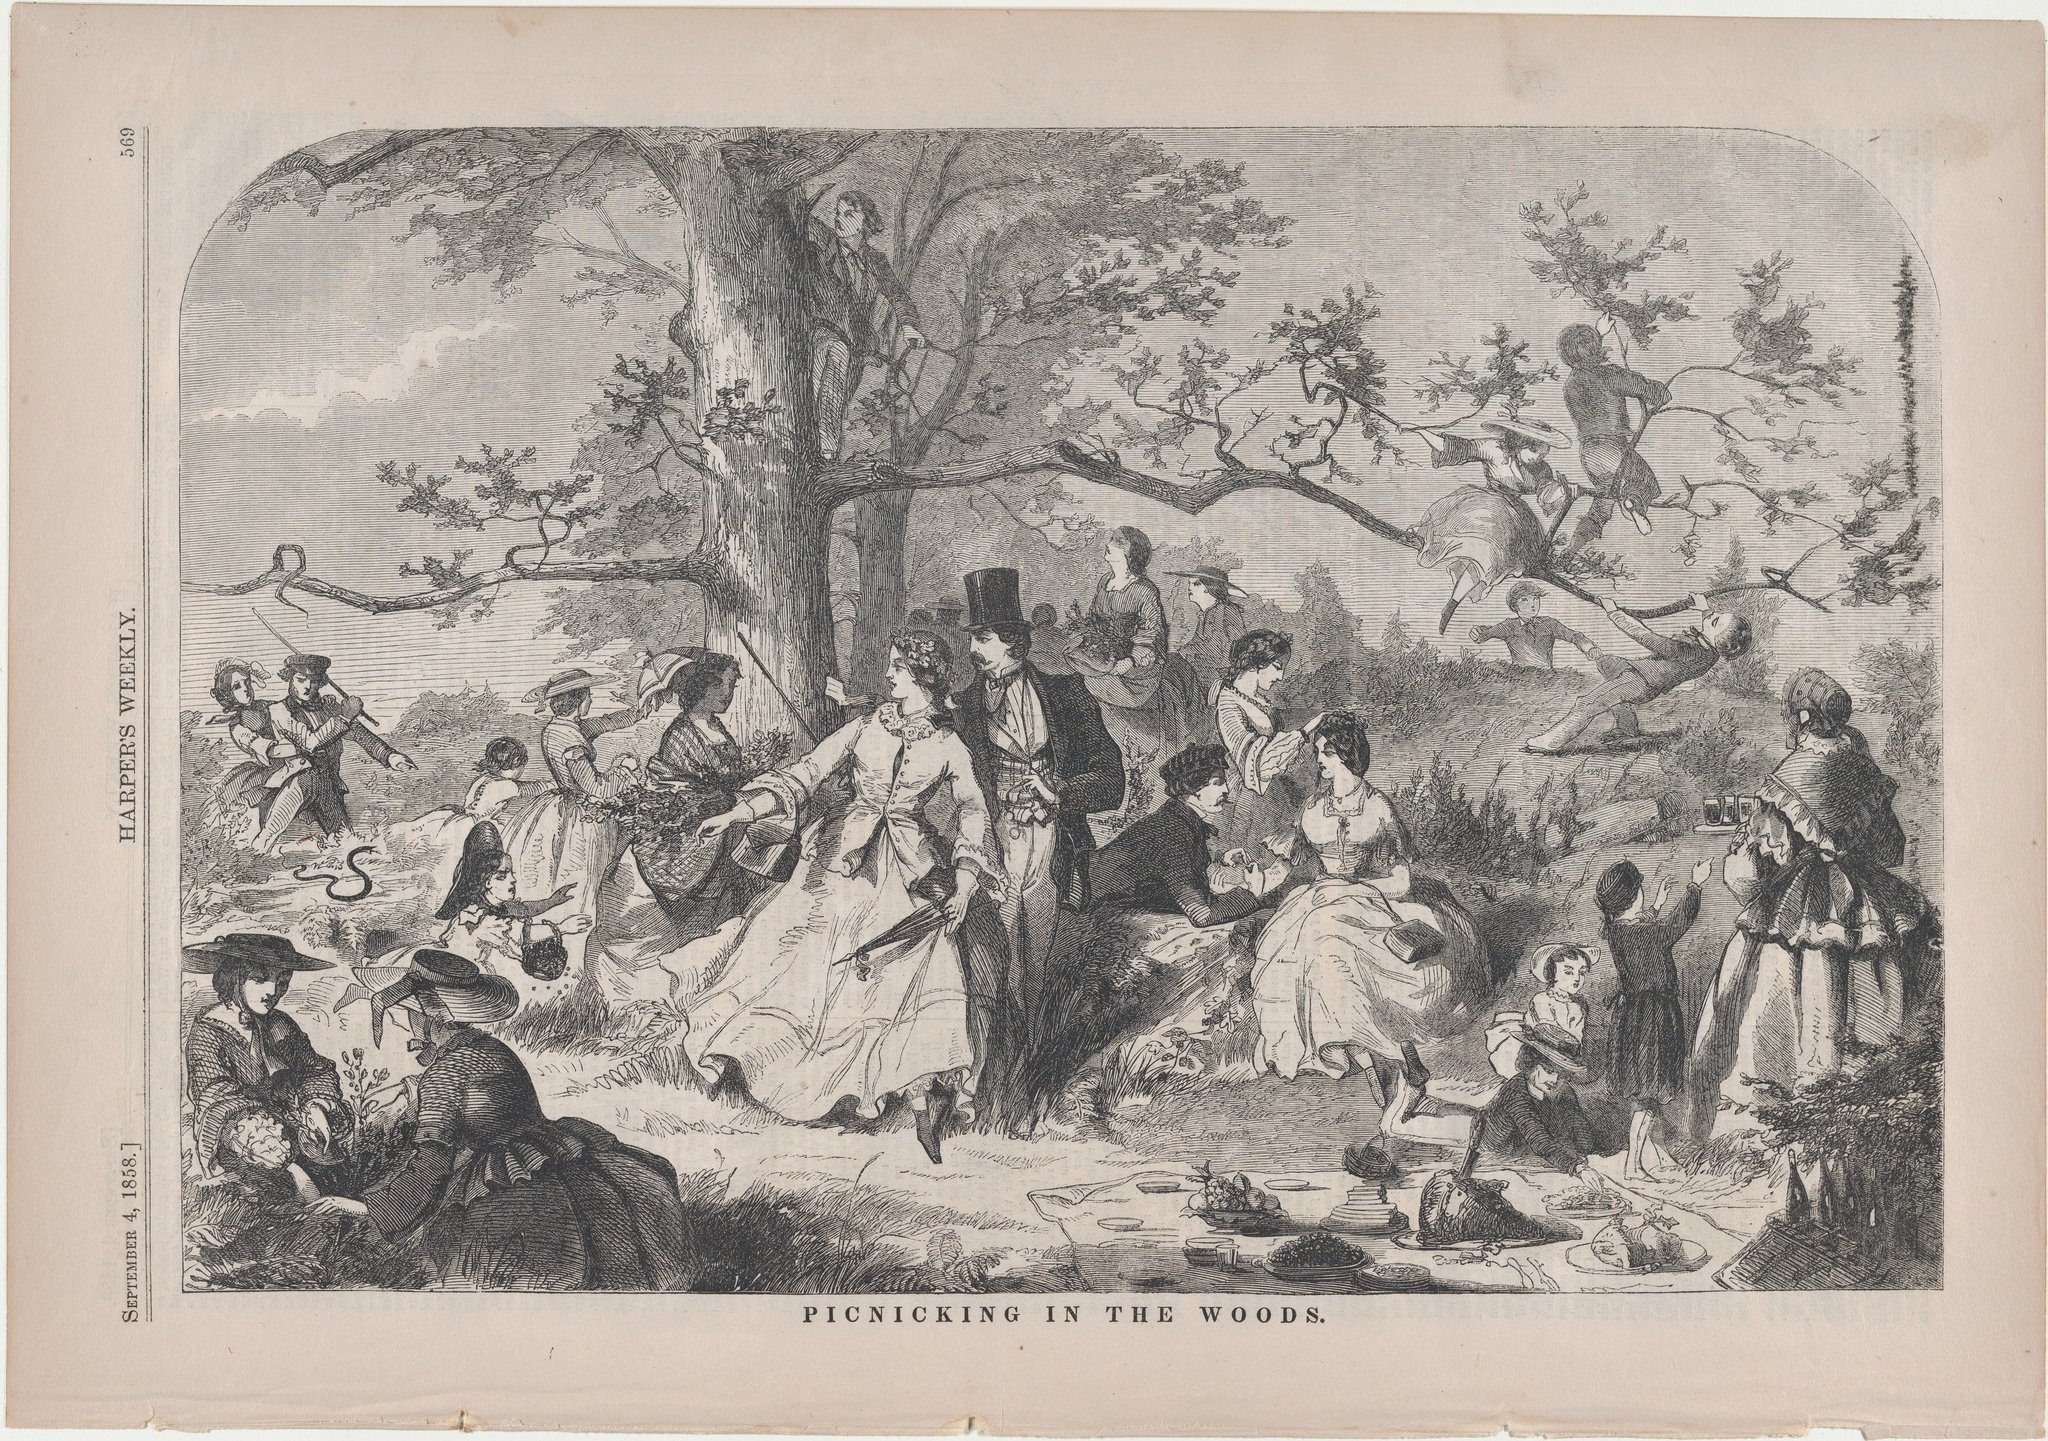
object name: print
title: Picnicking in the Woods (from "Harper's Weekly," Vol. II)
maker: winslow homer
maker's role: artist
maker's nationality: american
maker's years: 1836-1910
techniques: engraving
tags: food,children,men,women,playing,picnics